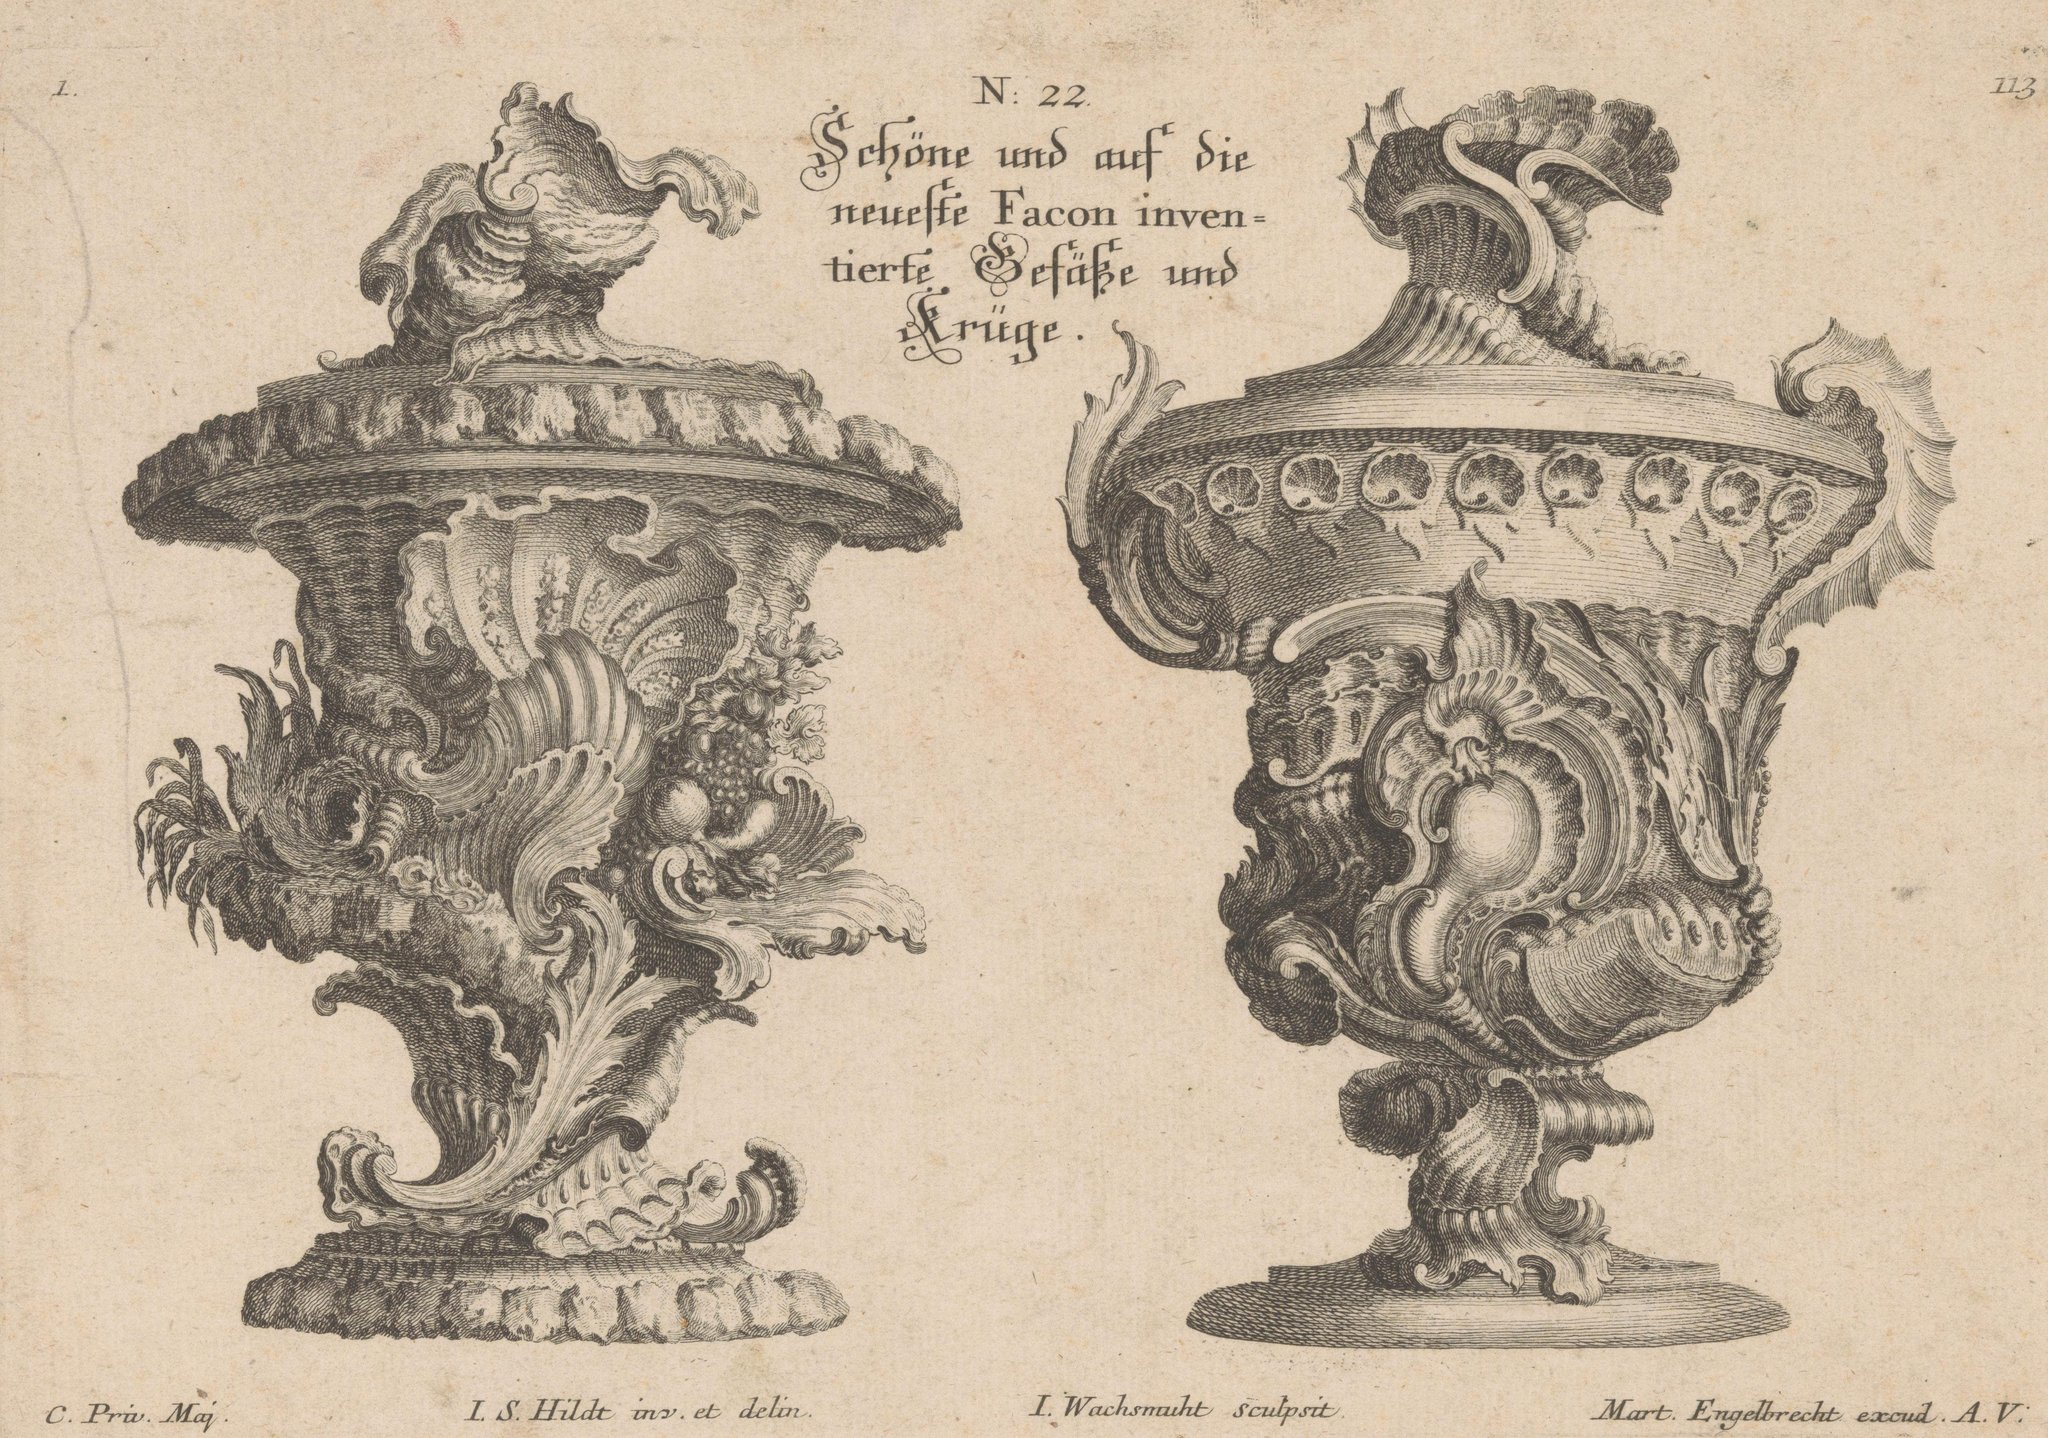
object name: ornament print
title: Siervazen met fruitmotieven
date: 1721-1756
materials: paper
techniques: etching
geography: augsburg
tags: rocaille ornament, fruits and vegetables ~ ornament, vase ~ ornament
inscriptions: collector's mark: Lugt 2760, collector's mark: Lugt 2228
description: Twee rocaille siervazen. De linkervaas is met fruitmotieven gedecoreerd. Prentnummer 113, uitgeversnummer 22.